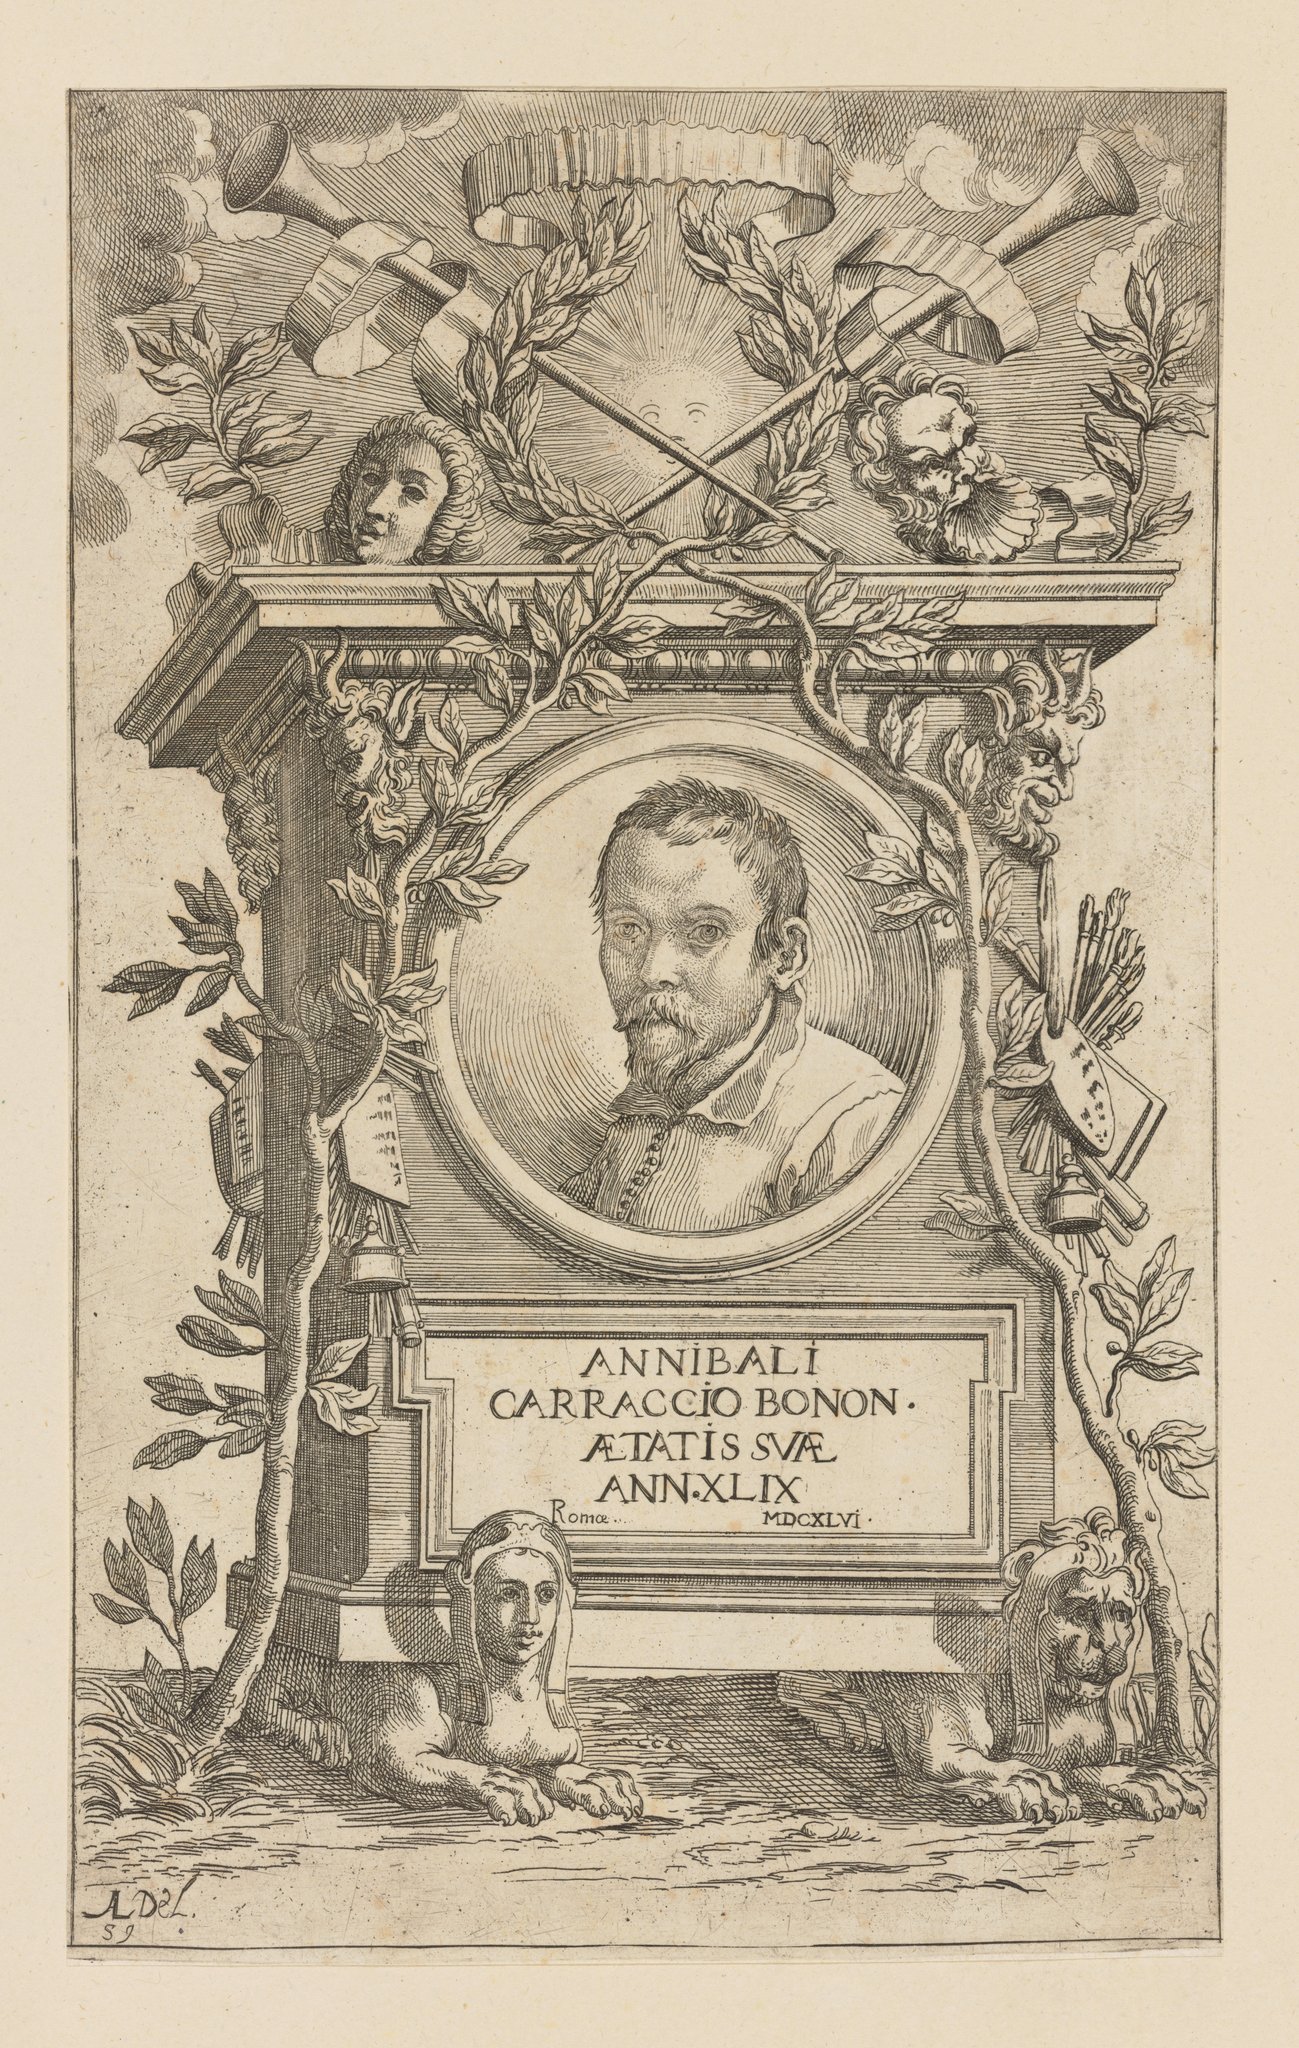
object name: print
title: Title page with portrait of Annibale Carracci for the series 'Diverse Figure' (later known as 'Arti di Bologna')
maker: simon guillain ii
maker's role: artist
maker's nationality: french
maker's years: 1618-1718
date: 1646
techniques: etching